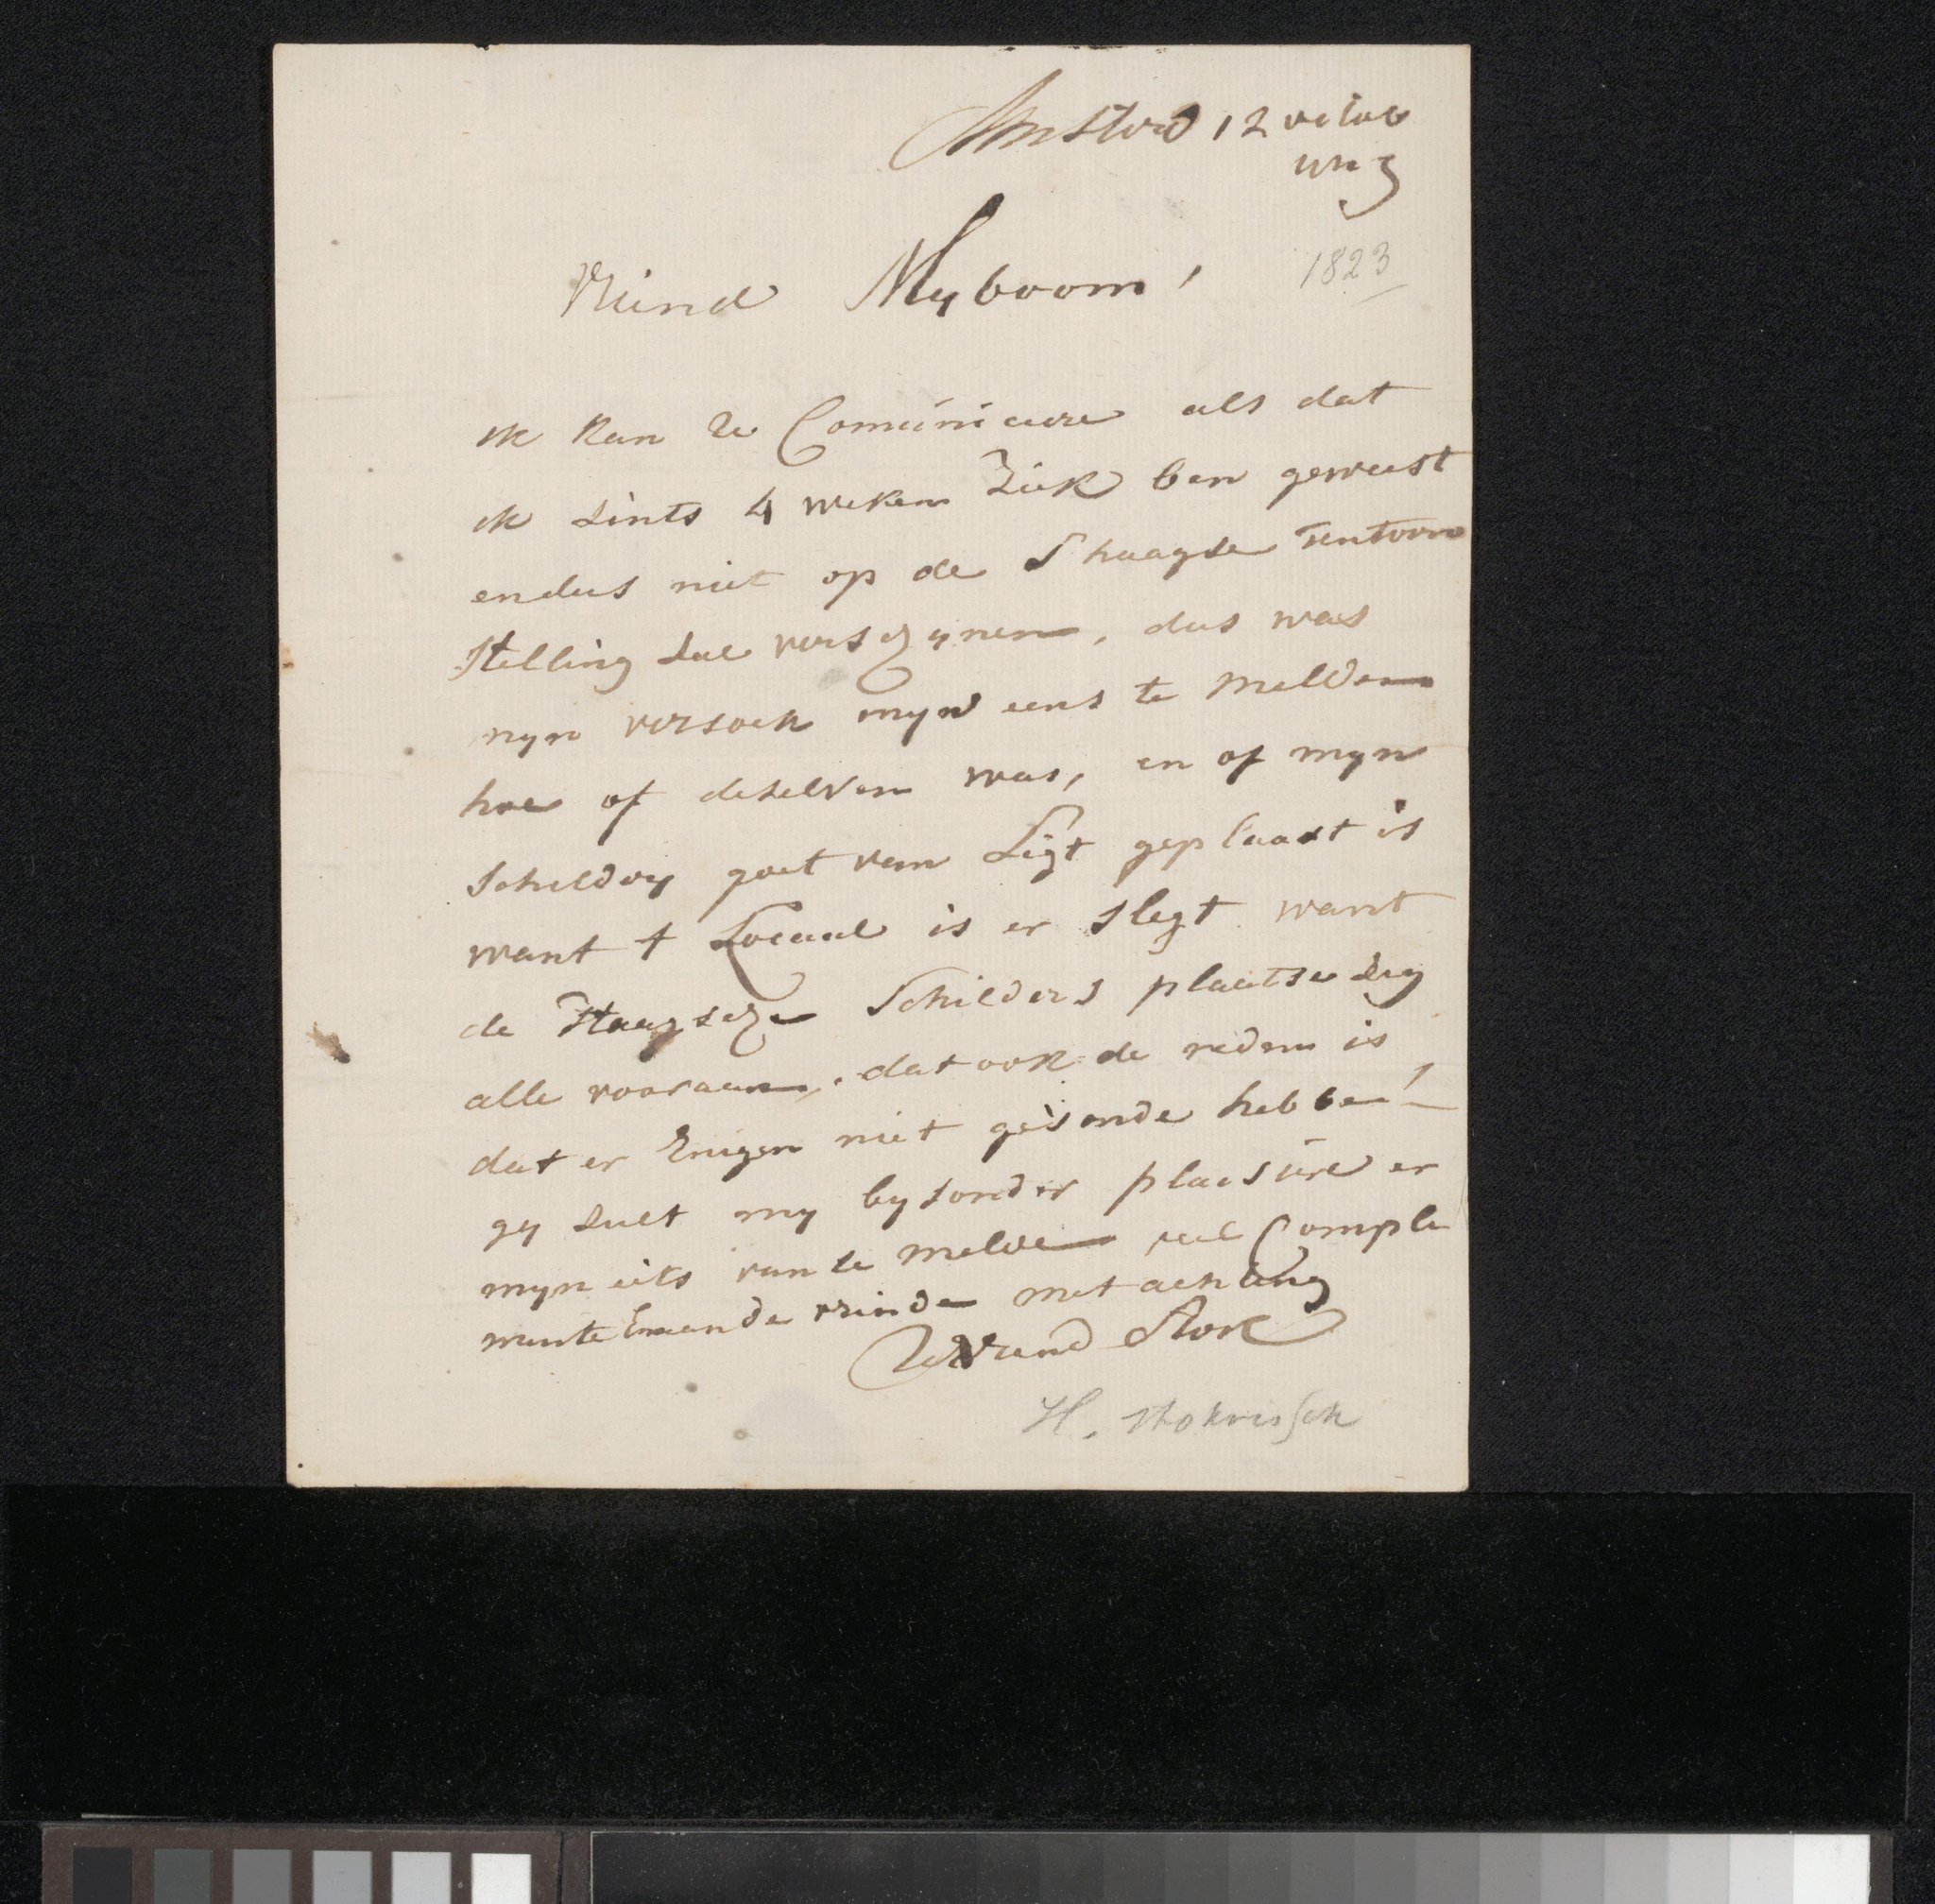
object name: letter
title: Brief aan de heer Meijboom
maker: hendrik stokvisch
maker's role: draughtsman, painter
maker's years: 1768-1820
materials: ink, paper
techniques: pen, writing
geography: amsterdam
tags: painting (including book-illumination, miniature-painting), exhibition ~ art, diseases, the hague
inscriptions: watermark